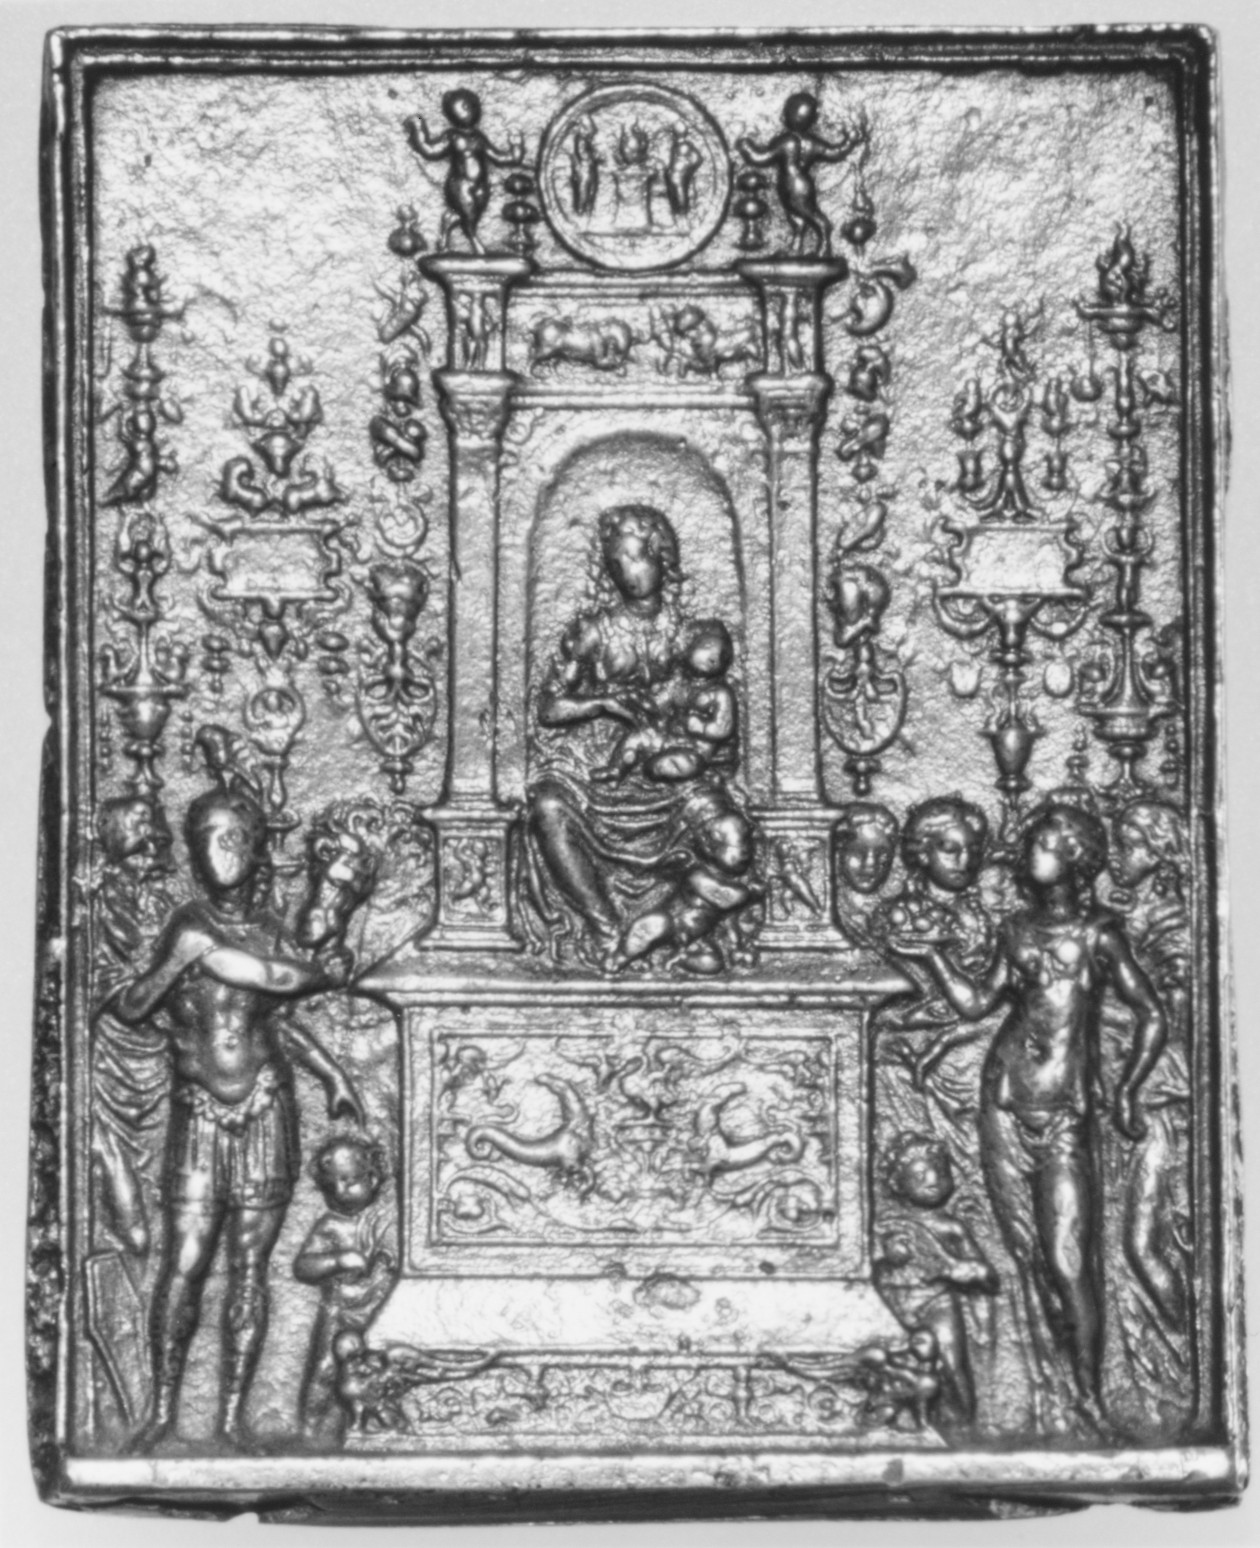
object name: plaquette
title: Virgin and Child Enthroned with Saints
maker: moderno (galeazzo mondella)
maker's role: artist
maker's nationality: italian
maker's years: 1467-1528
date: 1495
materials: bronze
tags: madonna and child,saints